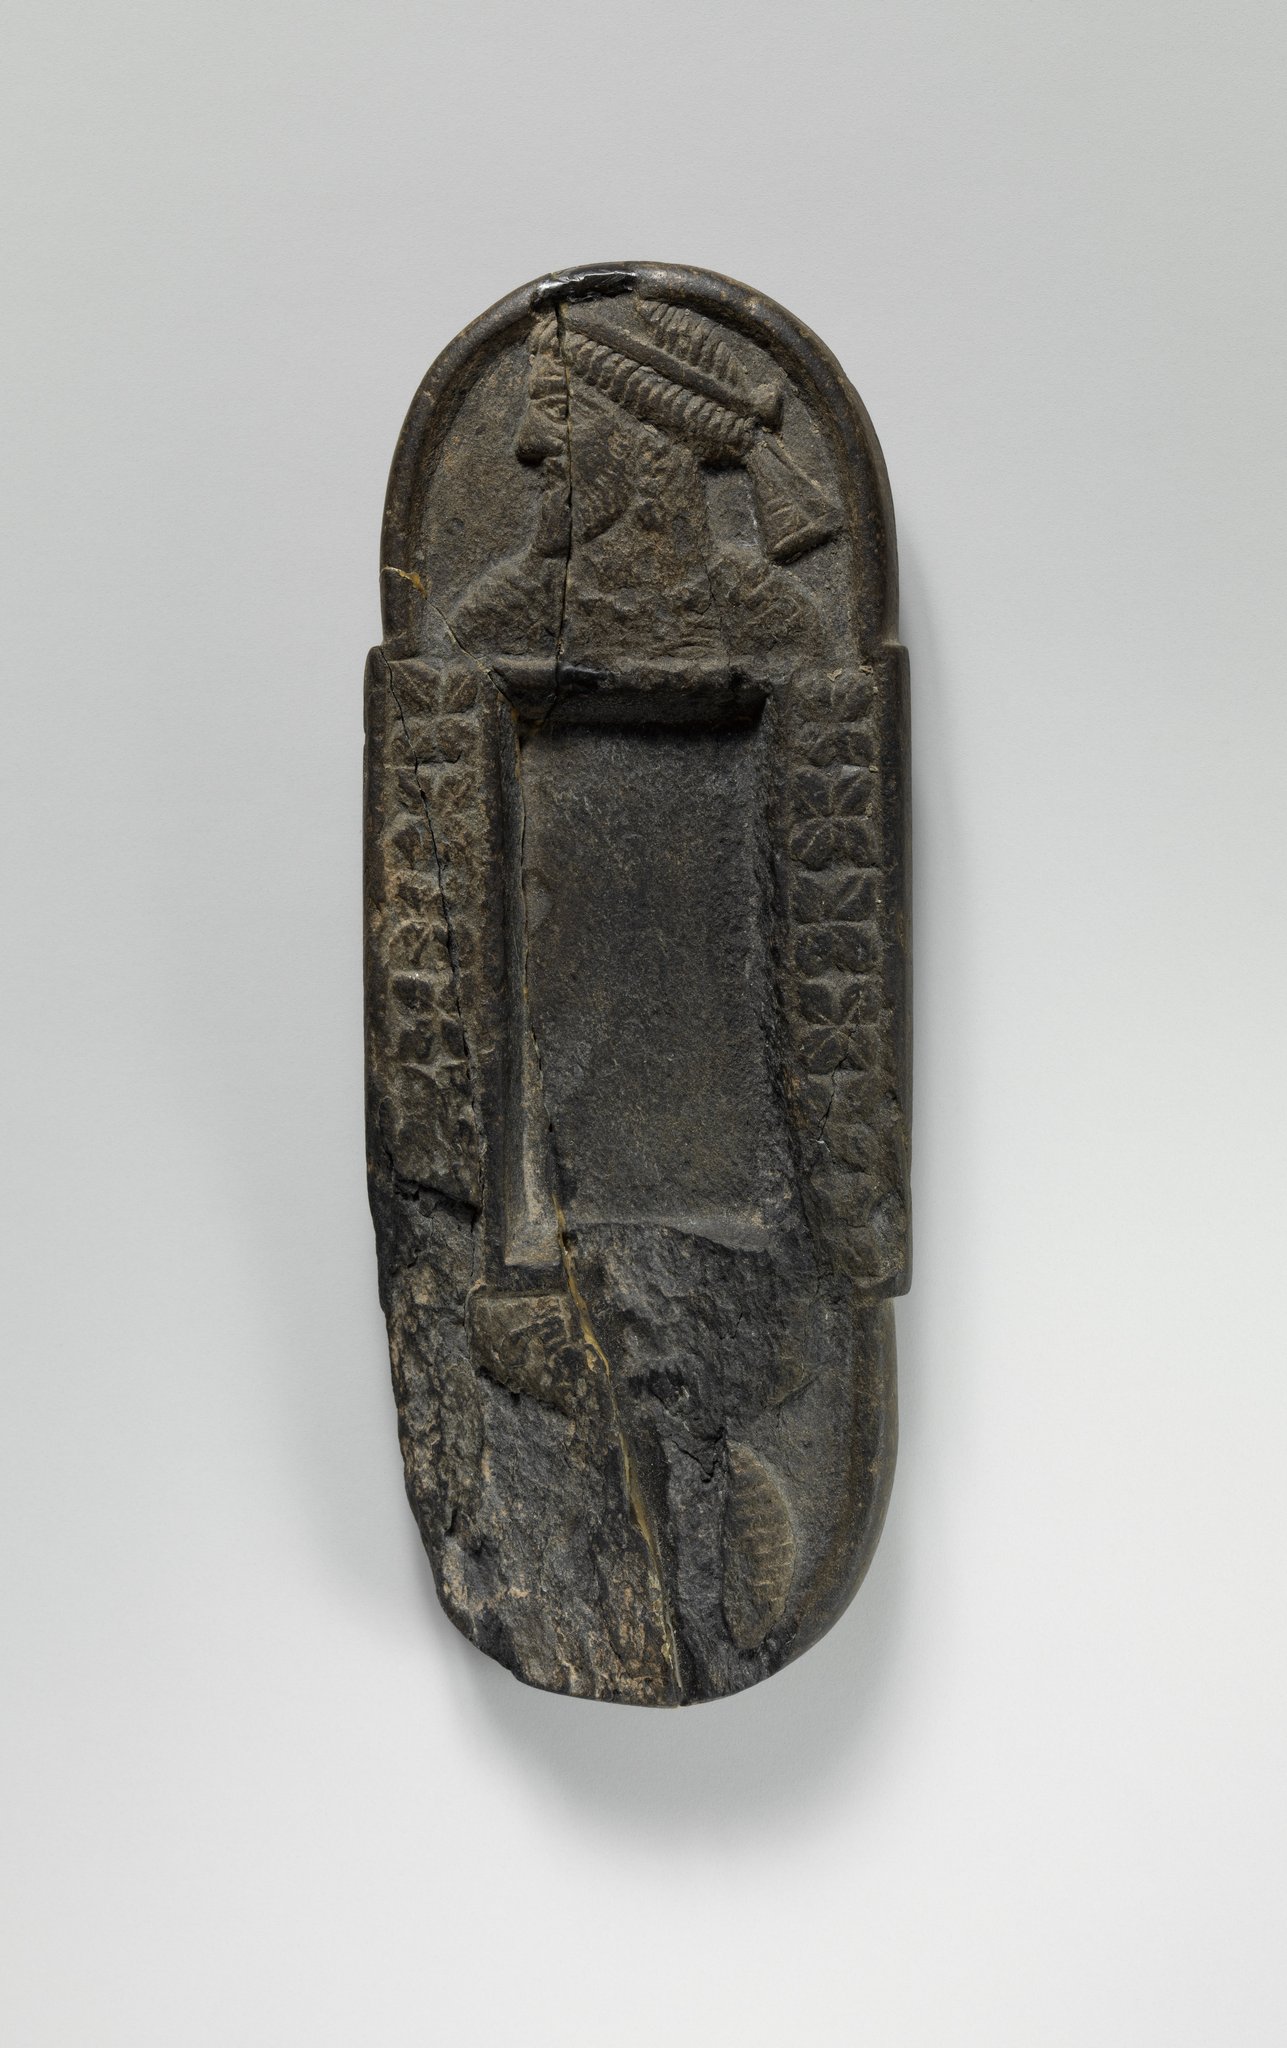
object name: cosmetic palette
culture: parthian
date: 1-100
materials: stone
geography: mesopotamia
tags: men